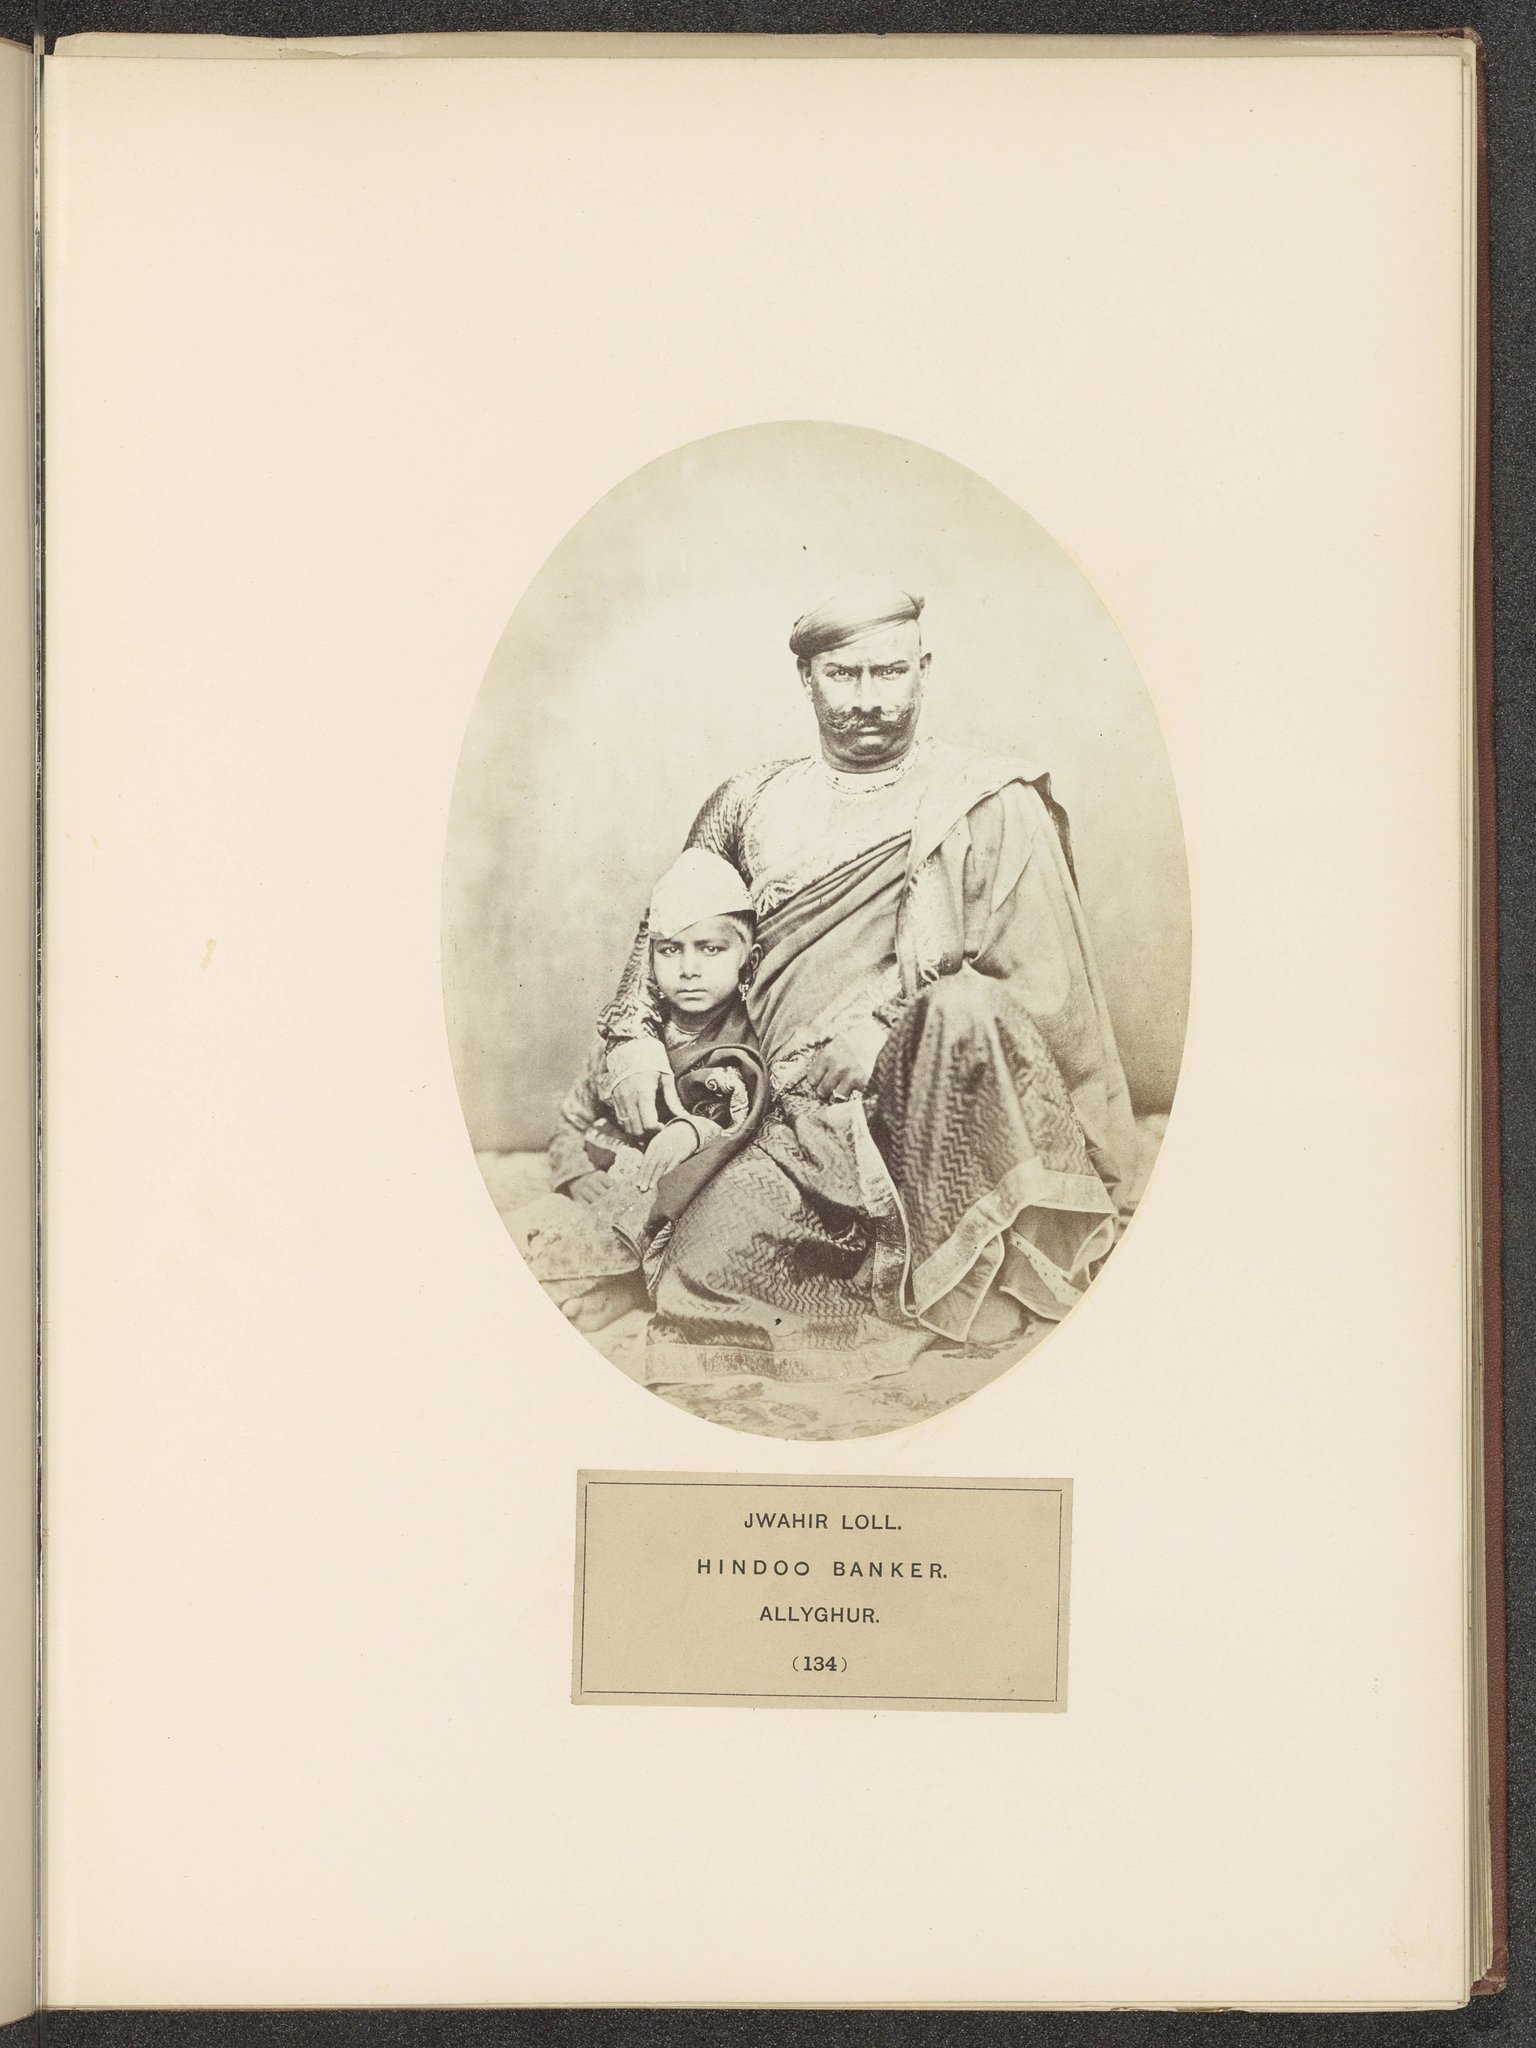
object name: photograph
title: Portrait of a child and Jwahir Loll, a Jain banker from Aligarh, Uttar Pradesh, India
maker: Anonymous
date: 1858-1868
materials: photographic support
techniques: albumen print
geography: aligarh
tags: banker, head-gear: turban, human races; peoples; nationalities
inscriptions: inscription: ‘JWAHIR LOLL./ HINDOO BANKER./ ALLYGHUR.’, number: ‘(134)’